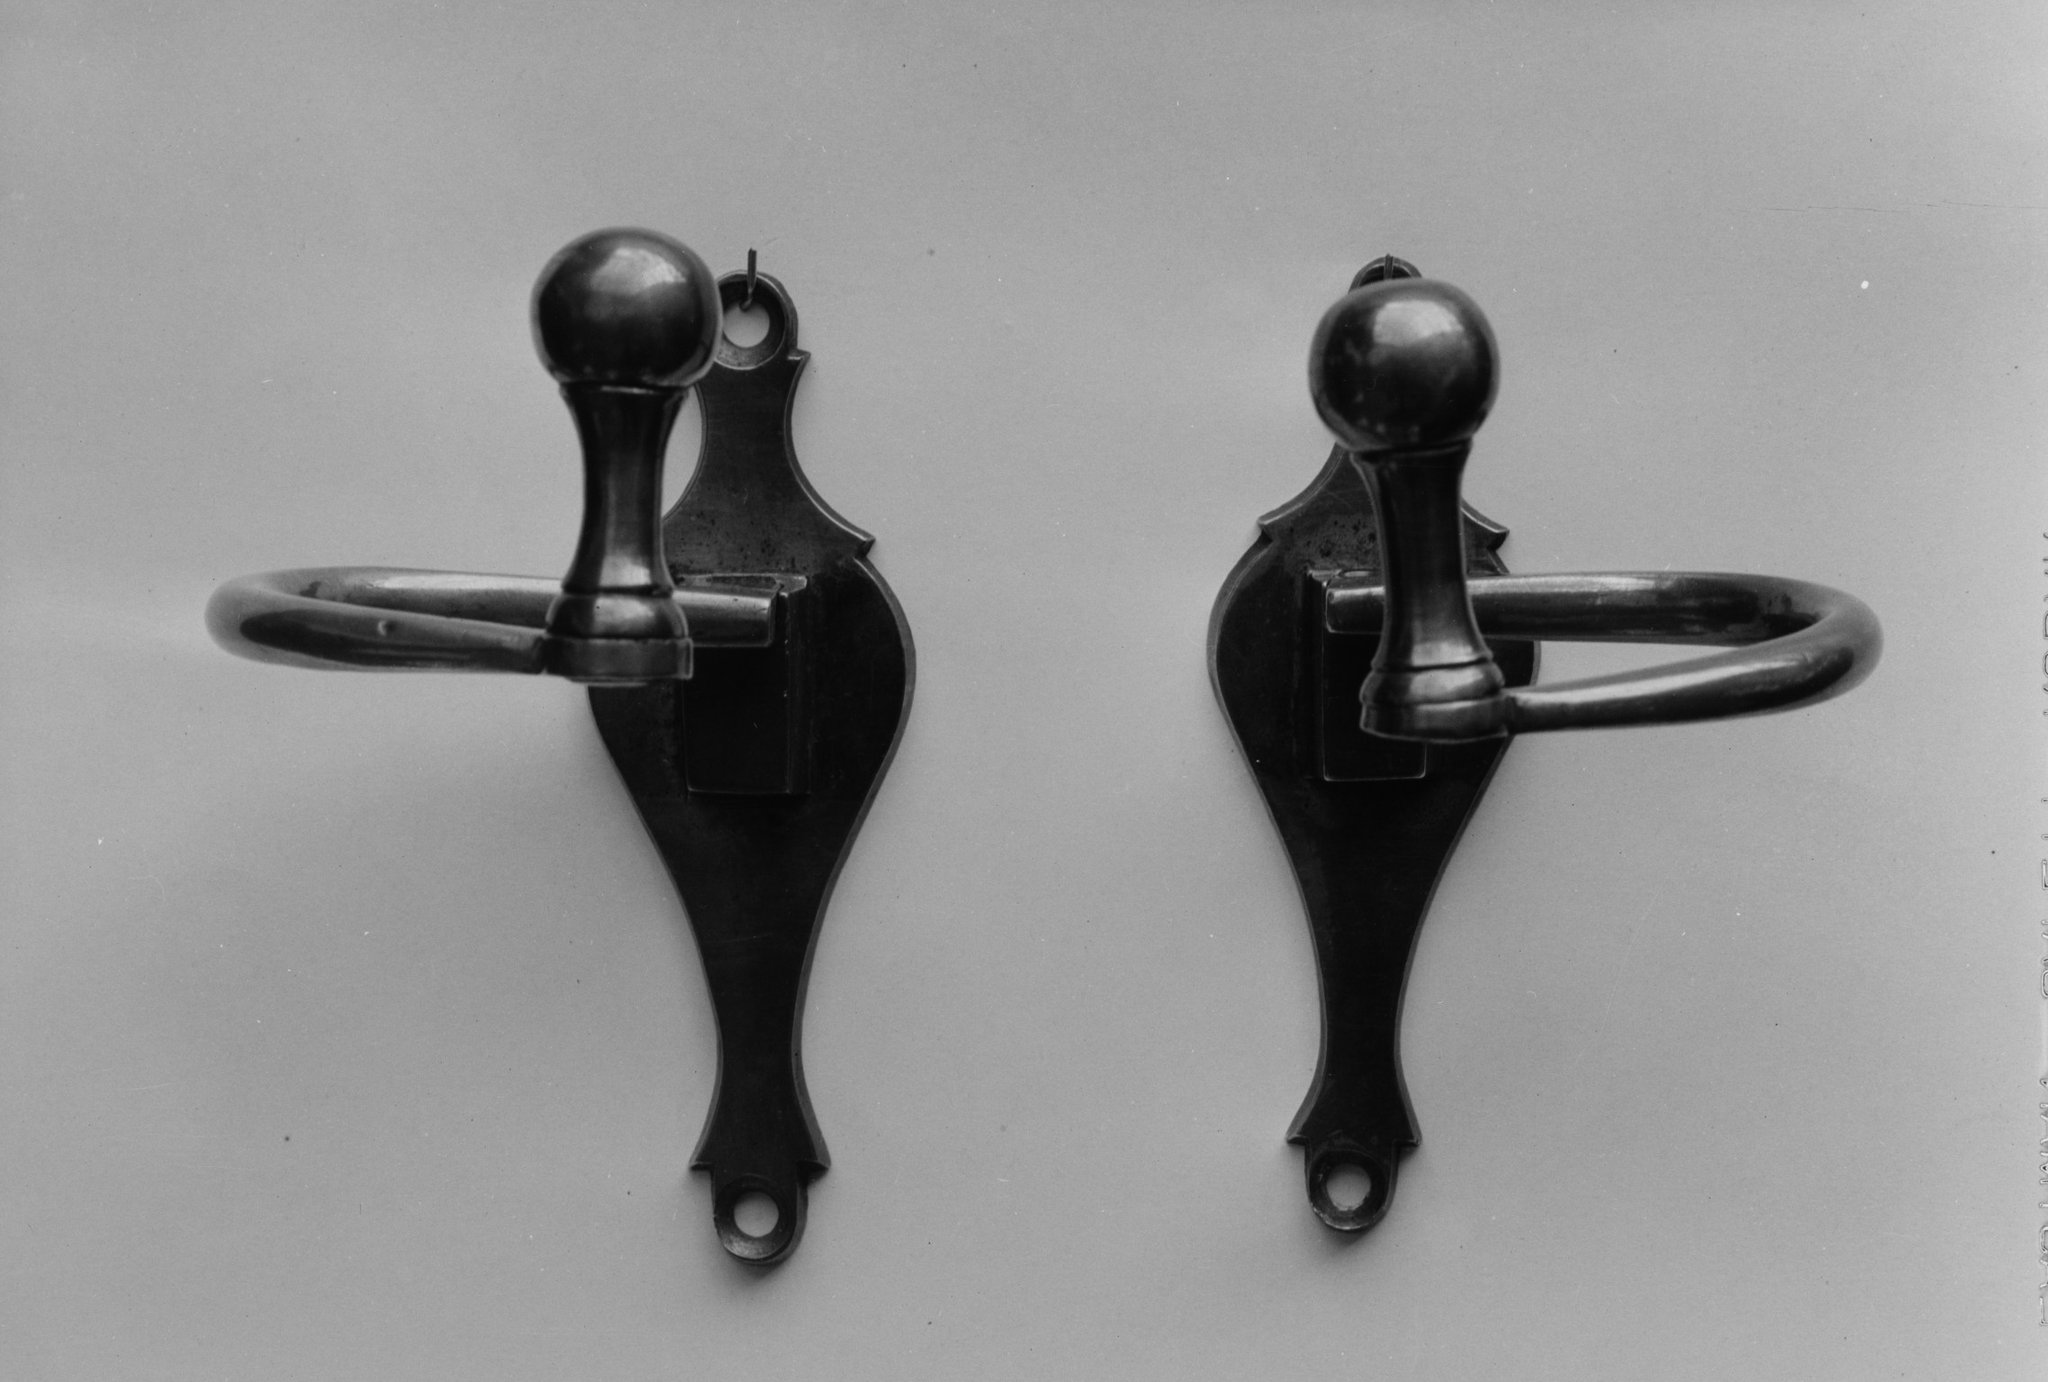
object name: jamb hook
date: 1750-1765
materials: iron, metal